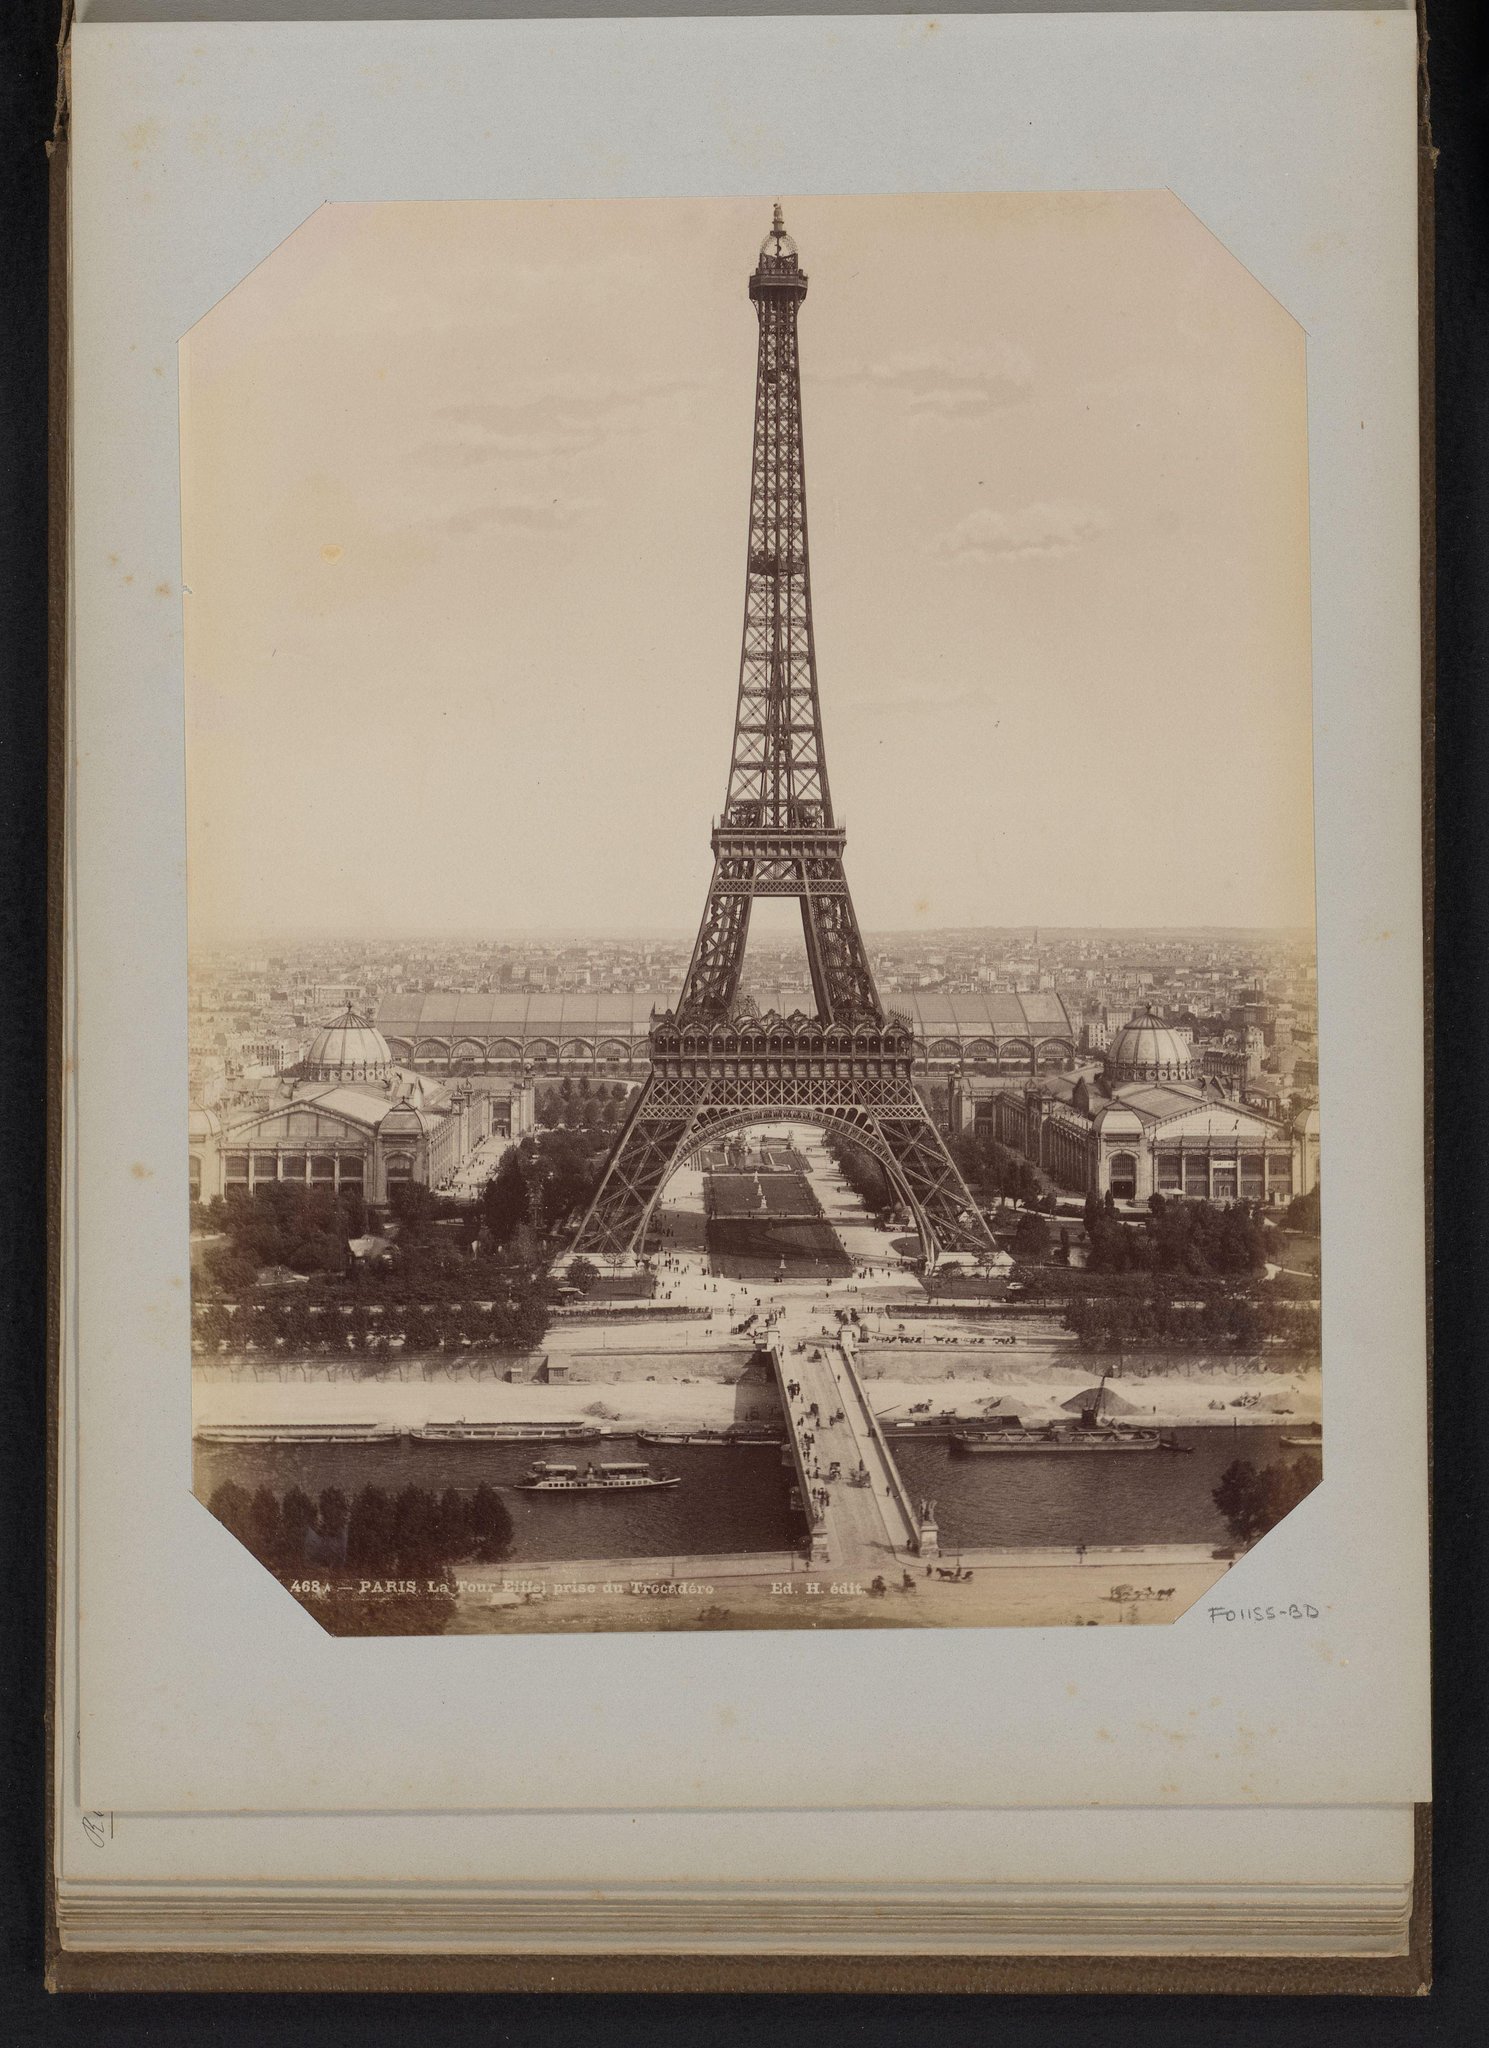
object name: album leaf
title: Gezicht op de Eiffeltoren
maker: edouard hautecoer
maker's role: publisher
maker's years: 1847-1904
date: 1890-1898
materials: photographic support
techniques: albumen print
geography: paris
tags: city-view in general; 'veduta' (+ city(-scape) with figures, staffage), eiffel tower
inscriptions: retailer's mark: ‘E. Hautecoeur/ Estampes Photographies/ 35 Avenue de l'Opéra, 35/ Paris’, inscription: ‘468A - Paris. La Tour Eiffel prise de Trocadéro. Ed. H. édit’